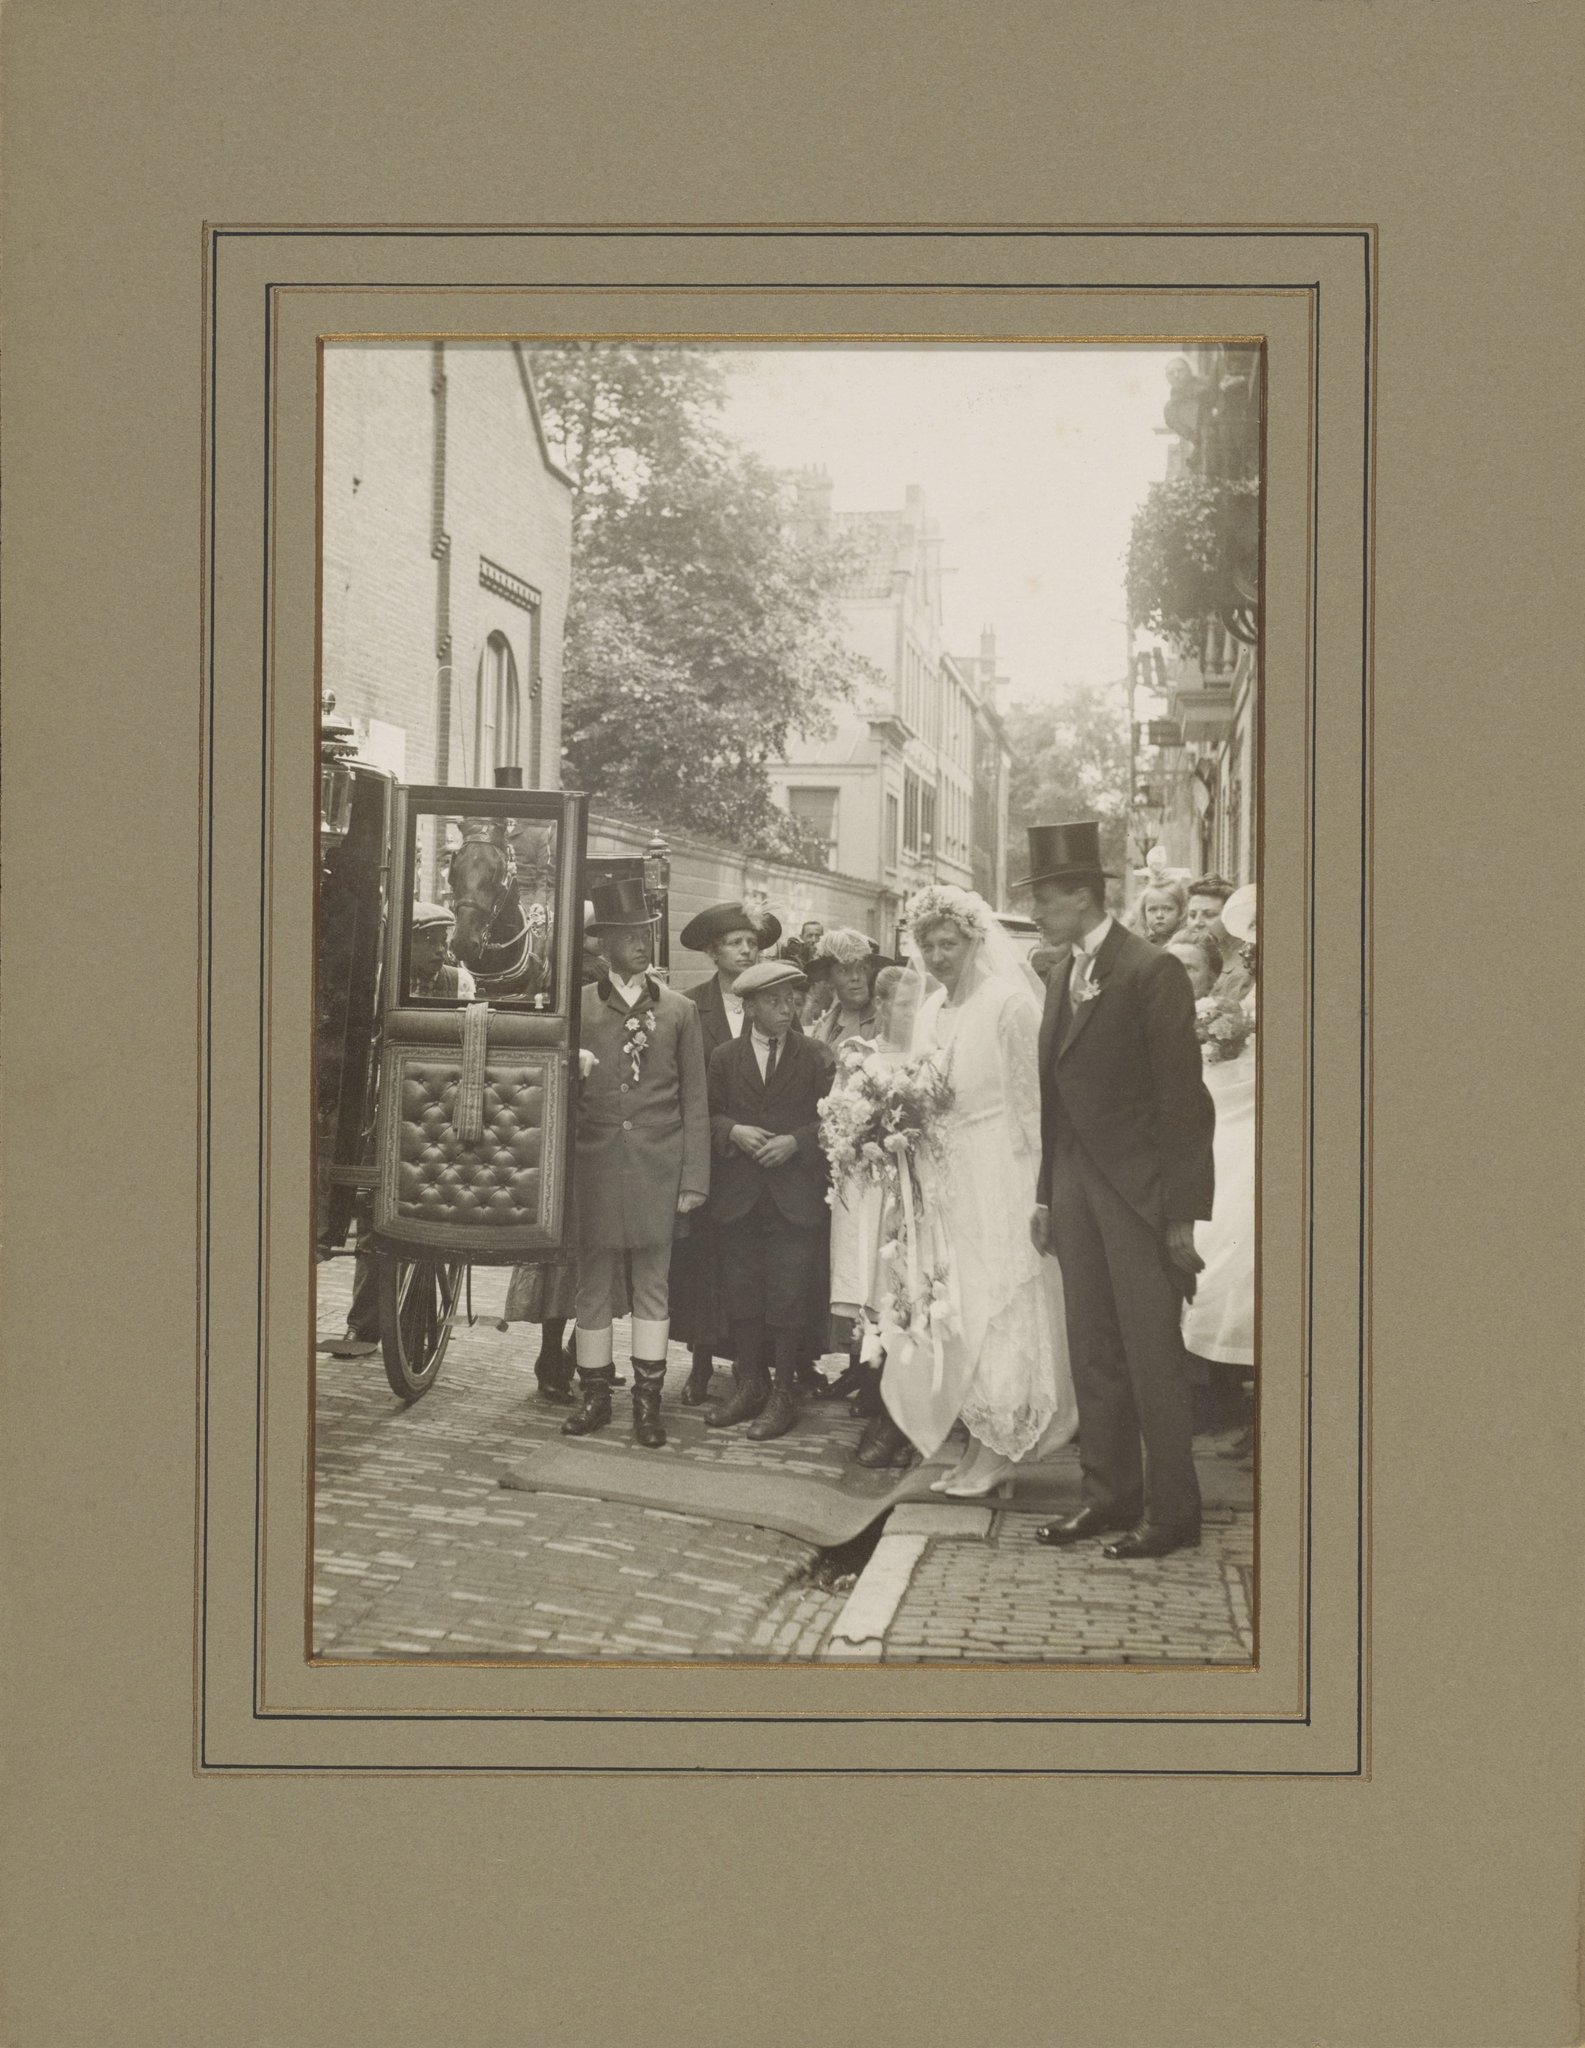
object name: photograph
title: Ir. H. Voorham, zijn bruid mevrouw H.B.J. Voorham-Helle en gasten bij een rijtuig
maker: Anonymous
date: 1921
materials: cardboard, paper, photographic support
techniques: gelatin silver print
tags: four-wheeled, animal-drawn vehicle, e.g.: cab, carriage, coach, bride and groom in wedding-dress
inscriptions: inscription: ‘Ir. Voorham en bruid’, number: ‘R.B.K. 1982-32’